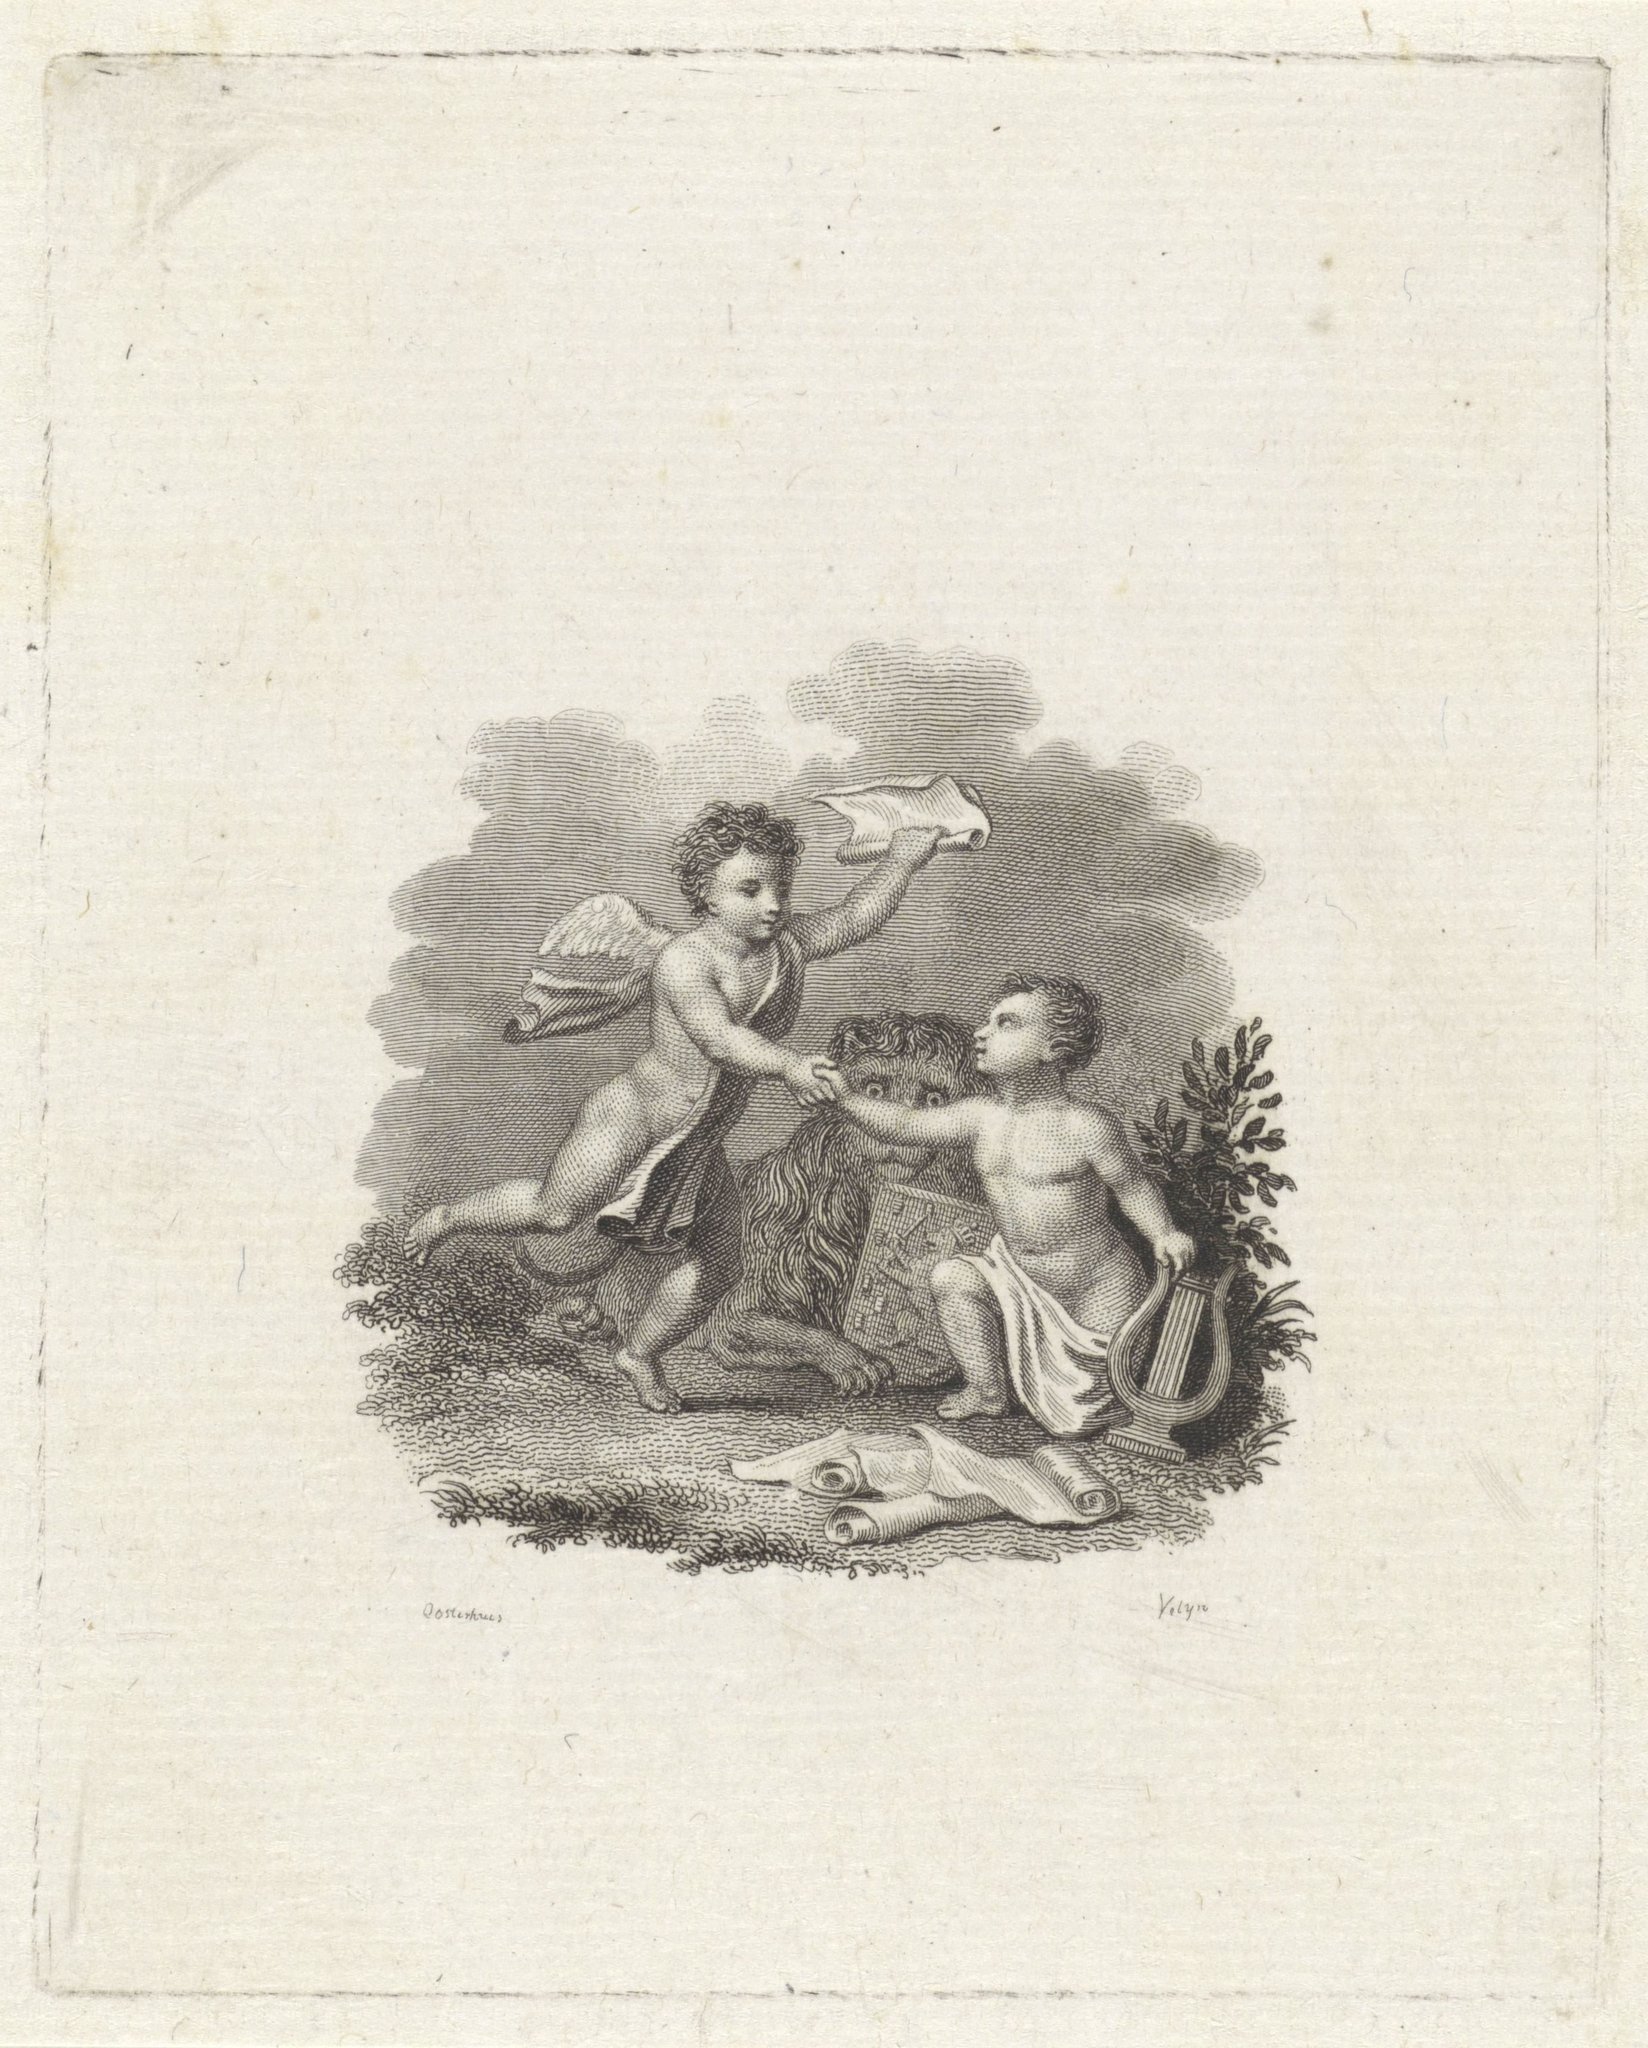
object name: print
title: Twee putti bij Hollandse Leeuw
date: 1797-1836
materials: paper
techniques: engraving, etching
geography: netherlands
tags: lyre, cithara, psaltery, paper (writing material), cupids: 'amores', 'amoretti', 'putti', symbols of particular nations, states, districts, etc.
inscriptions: collector's mark: Lugt 2228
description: Een gevleugelde putto met een rol papier geeft een andere putto met een lier de hand. Achter hen de Hollandse Leeuw met een wapenschild tussen zijn poten en op de voorgrond rollen papier.